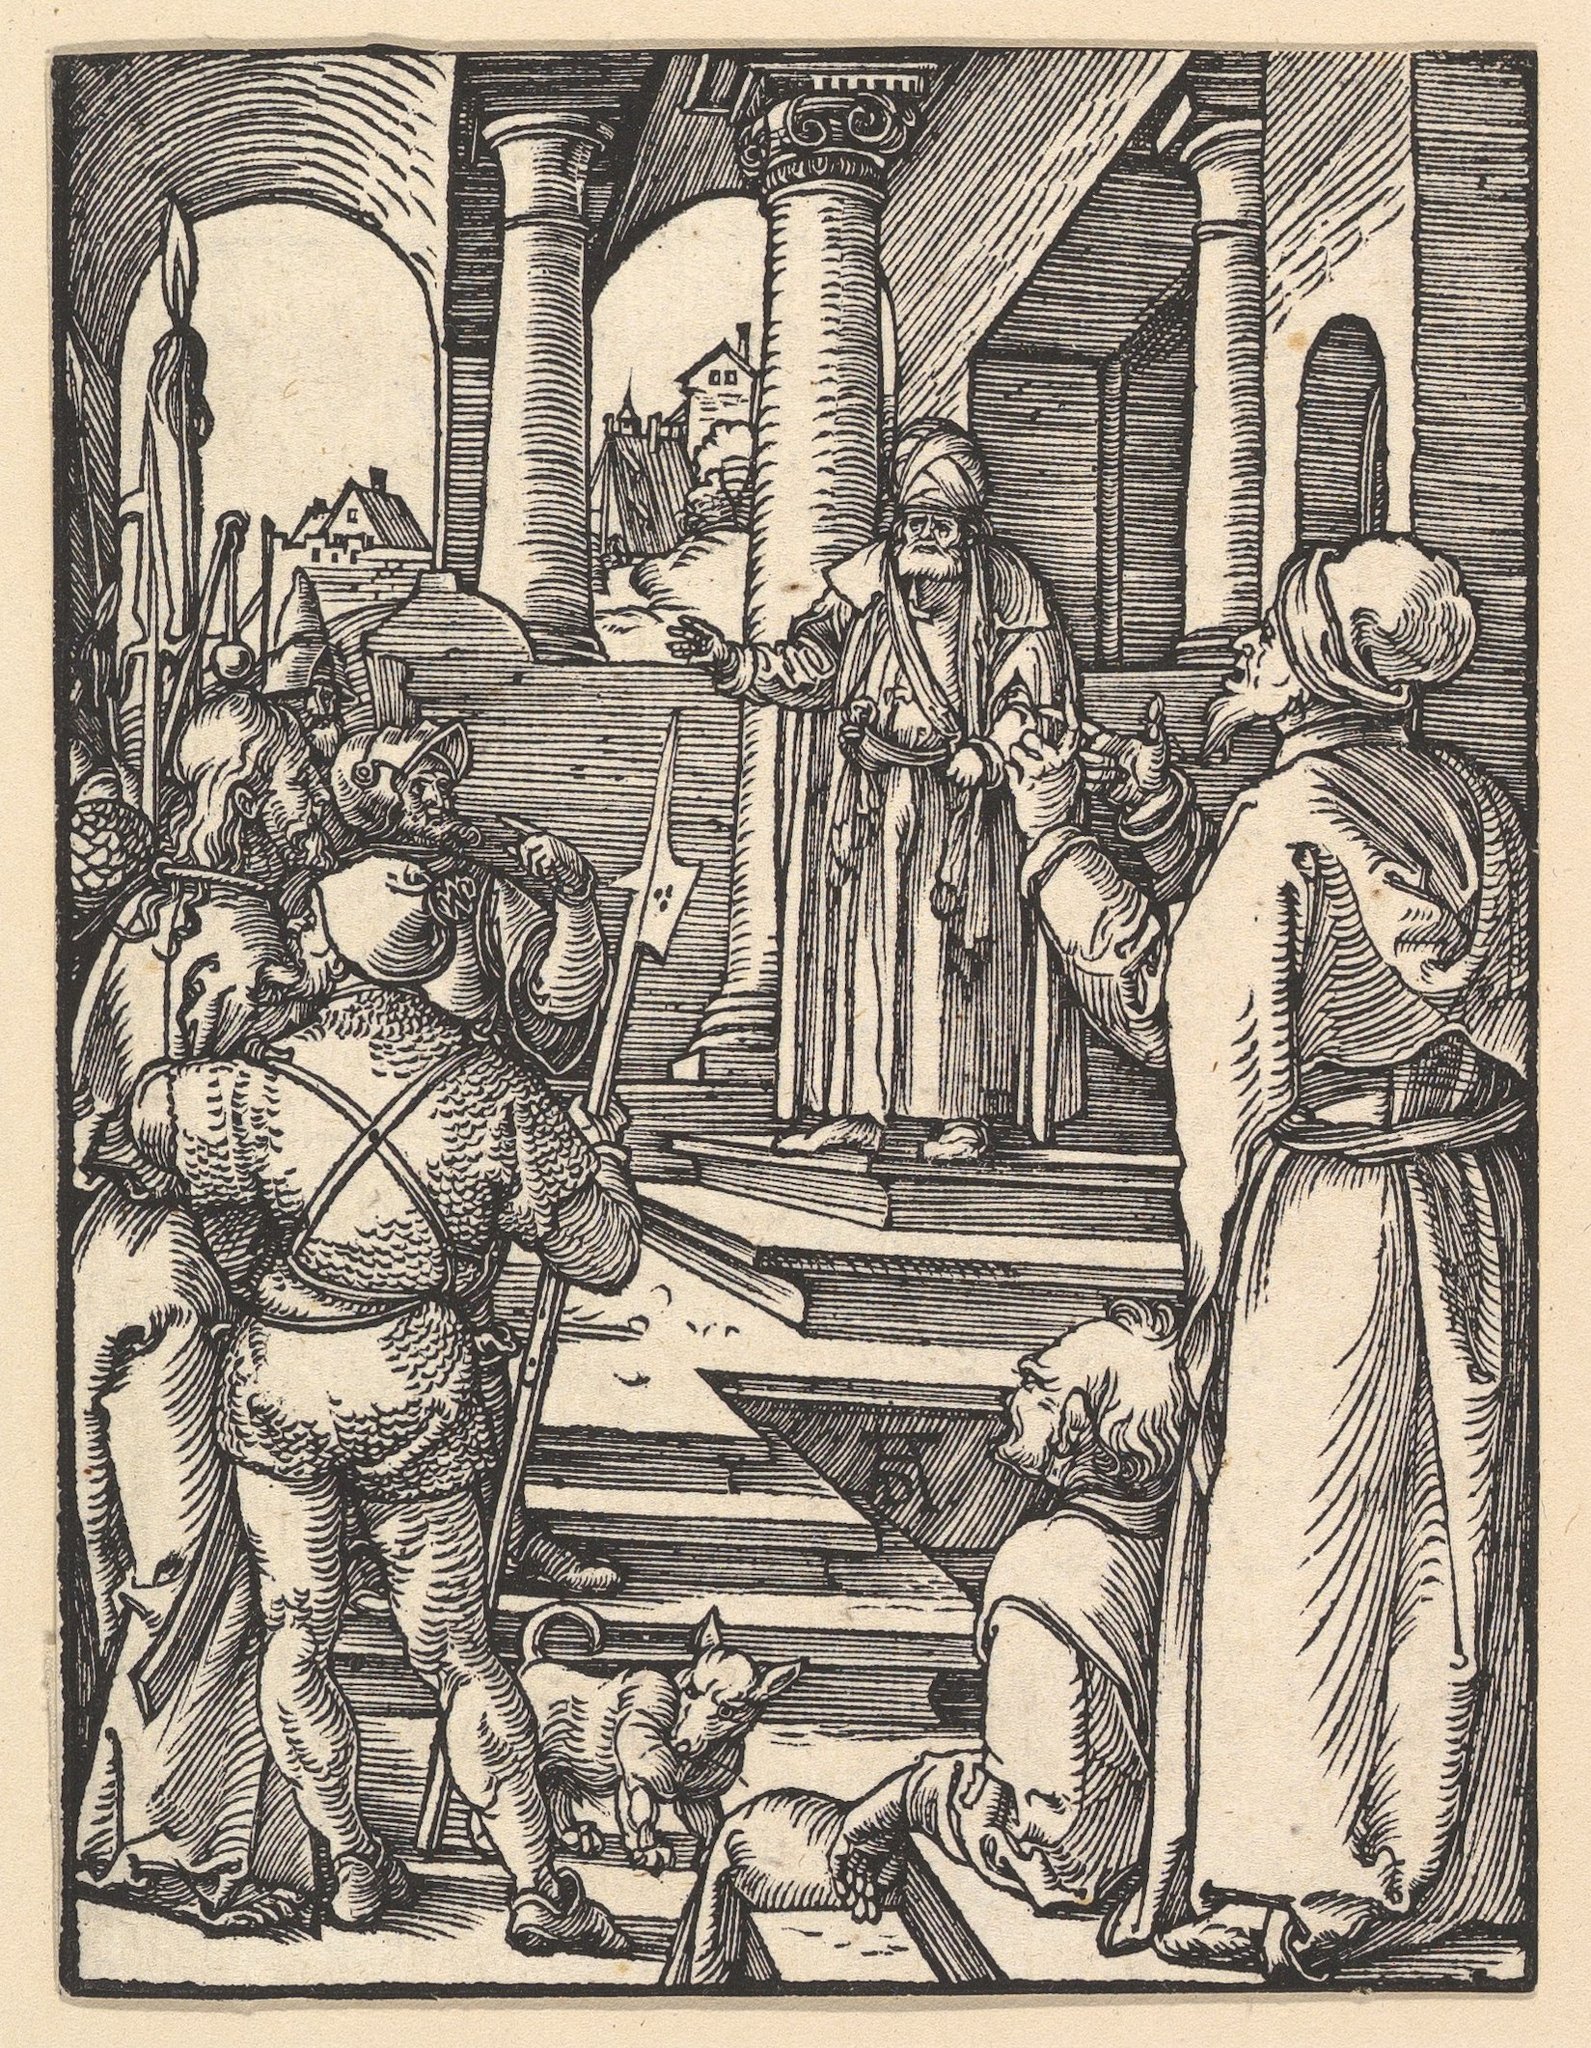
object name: print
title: Christ before Pilate, from "The Small Passion"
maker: albrecht dürer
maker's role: artist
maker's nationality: german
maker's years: 1471-1528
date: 1508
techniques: woodcut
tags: soldiers,weapons,men,dogs,christ,pilate